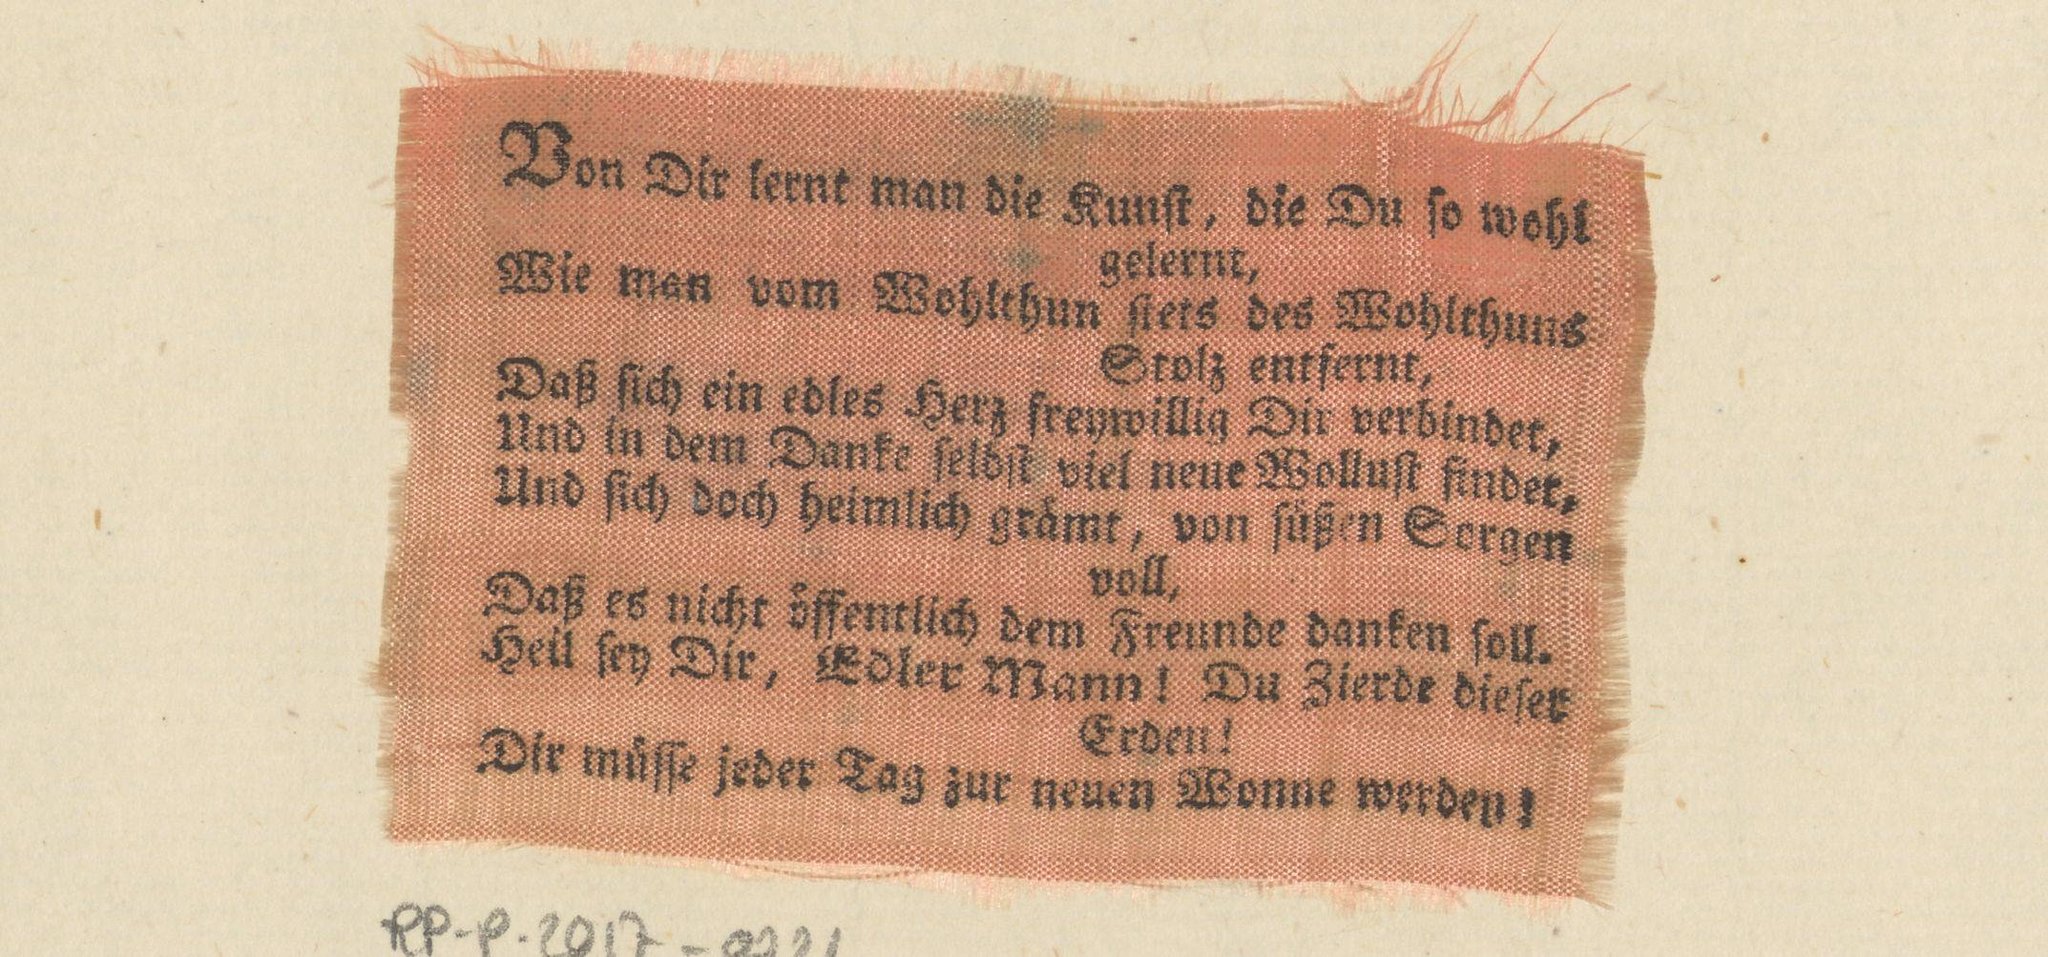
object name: text sheet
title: Gedicht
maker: Anonymous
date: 1850-1999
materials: silk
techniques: letterpress printing